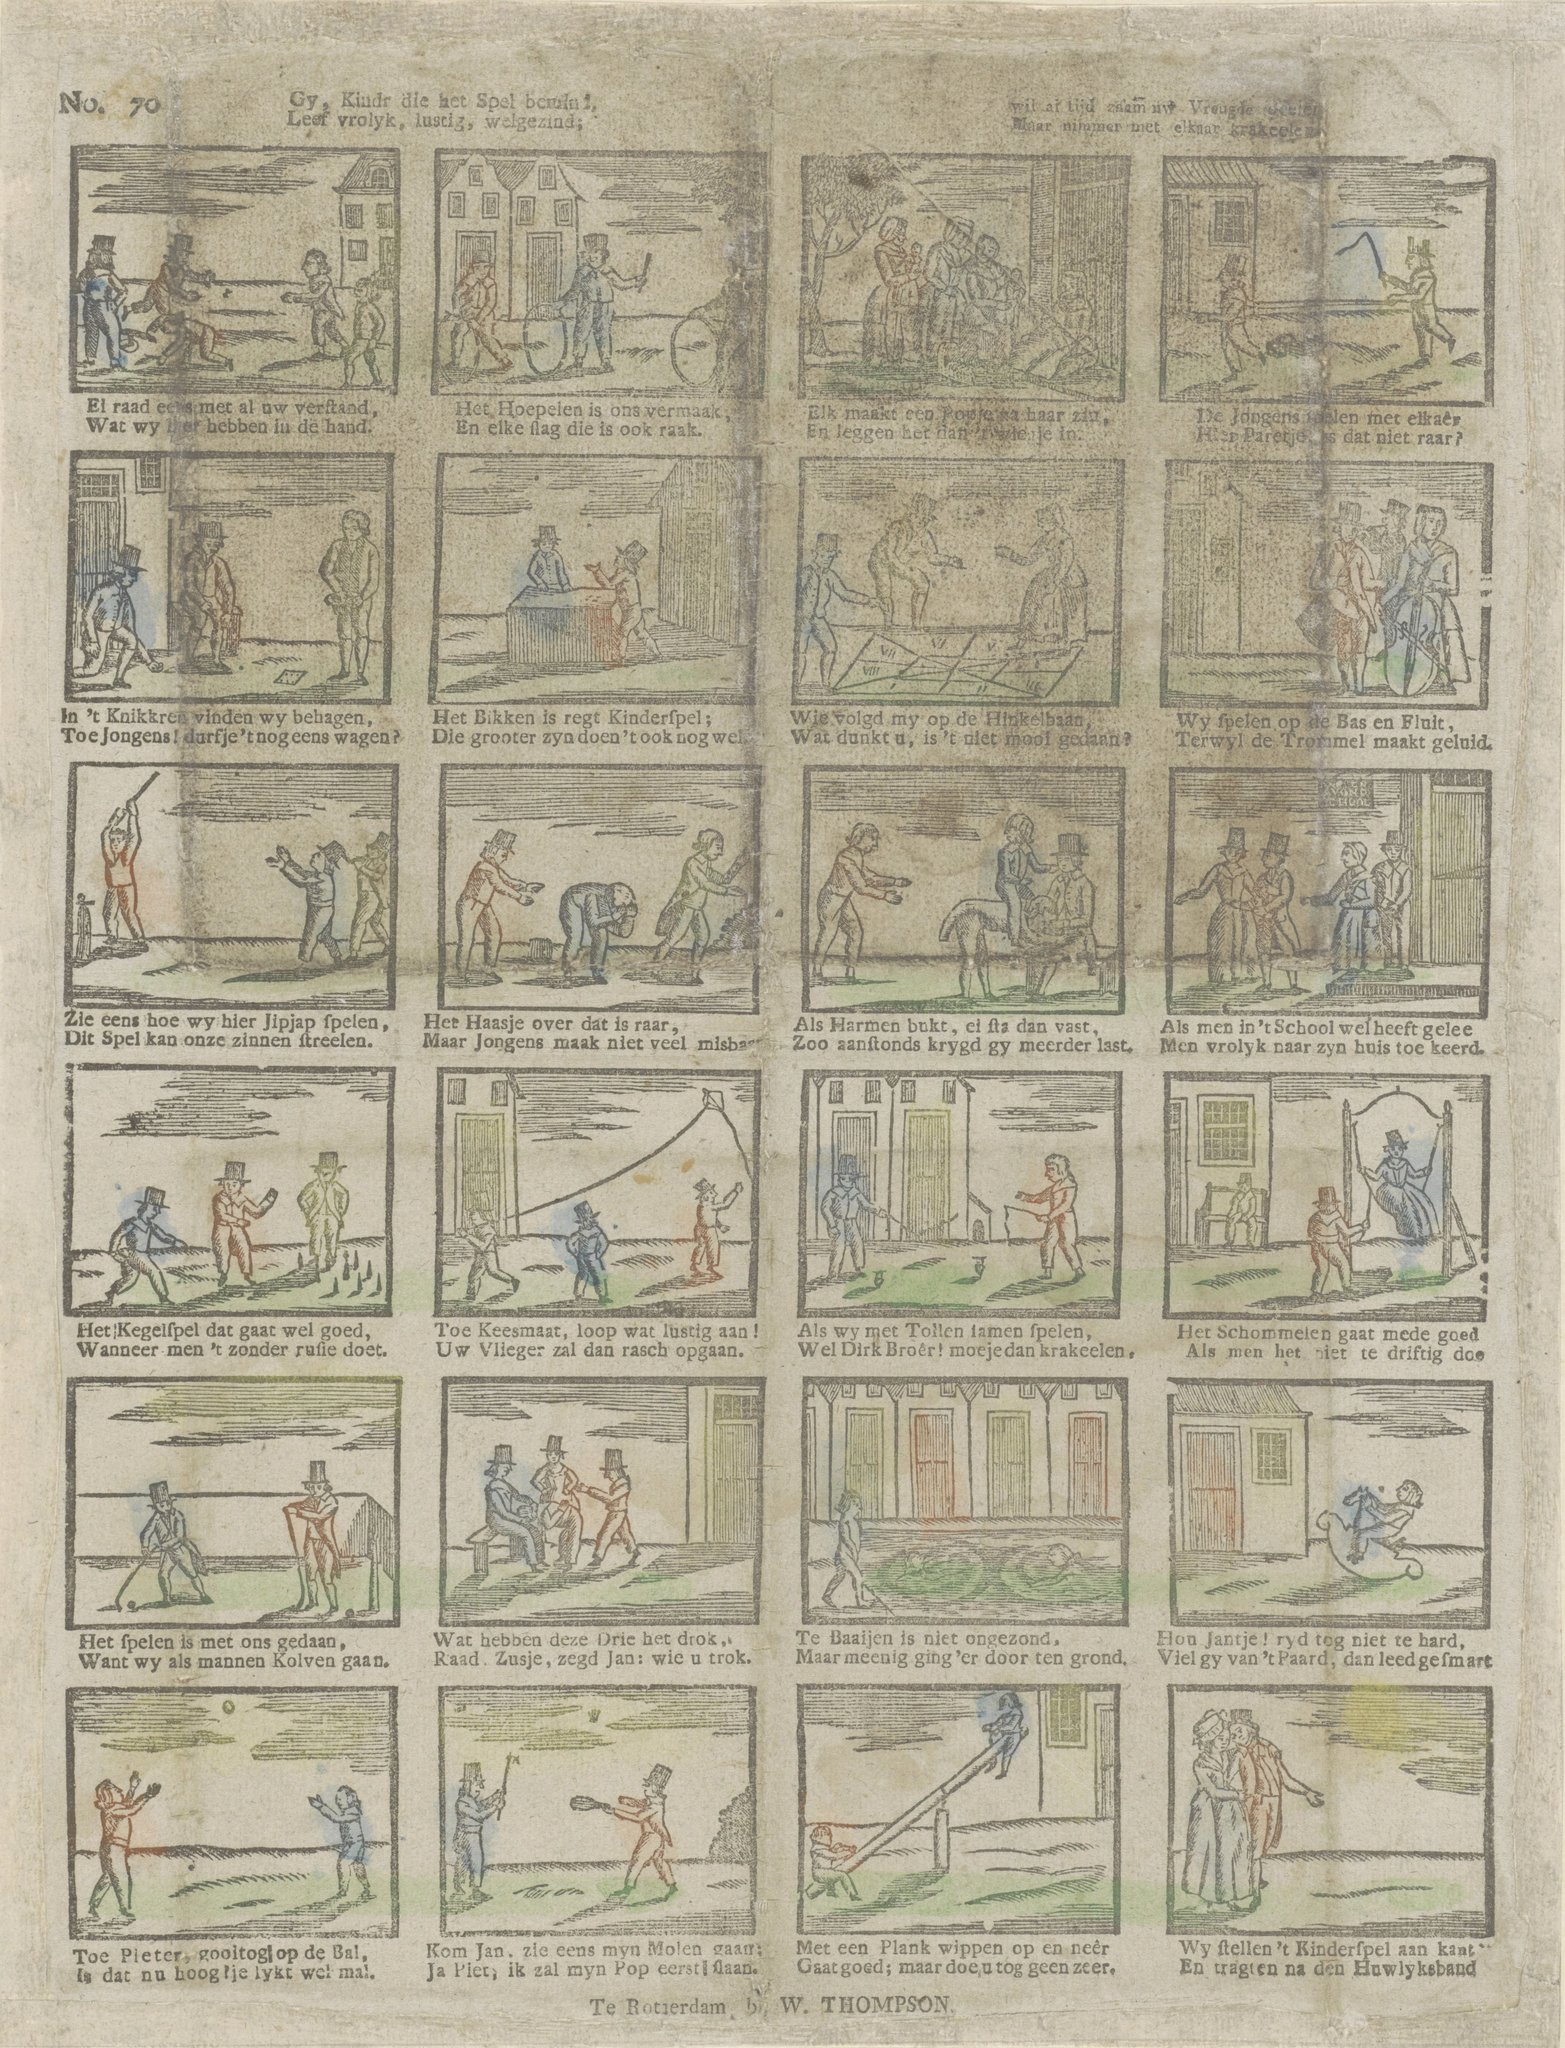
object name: print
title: Gy, kindren! die het spel bemind, / Leef vrolyk, lustig, welgezind; / Wil altijd zaam uw Vreugde deelen, / Maar nimmer met elkaar krakeelen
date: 1835-1837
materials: paper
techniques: colour, letterpress printing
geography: netherlands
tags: children's games and plays, bowling games (children's games), (flying a) kite, games using special objects (marbles, top, hoop, etc.)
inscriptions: collector's mark: Lugt 2760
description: Blad met 24 voorstellingen van kinderspelen, waaronder hoepelen, paardje spelen en haasje-over. Onder elke afbeelding een tweeregelig vers. Genummerd linksboven: No. 70.